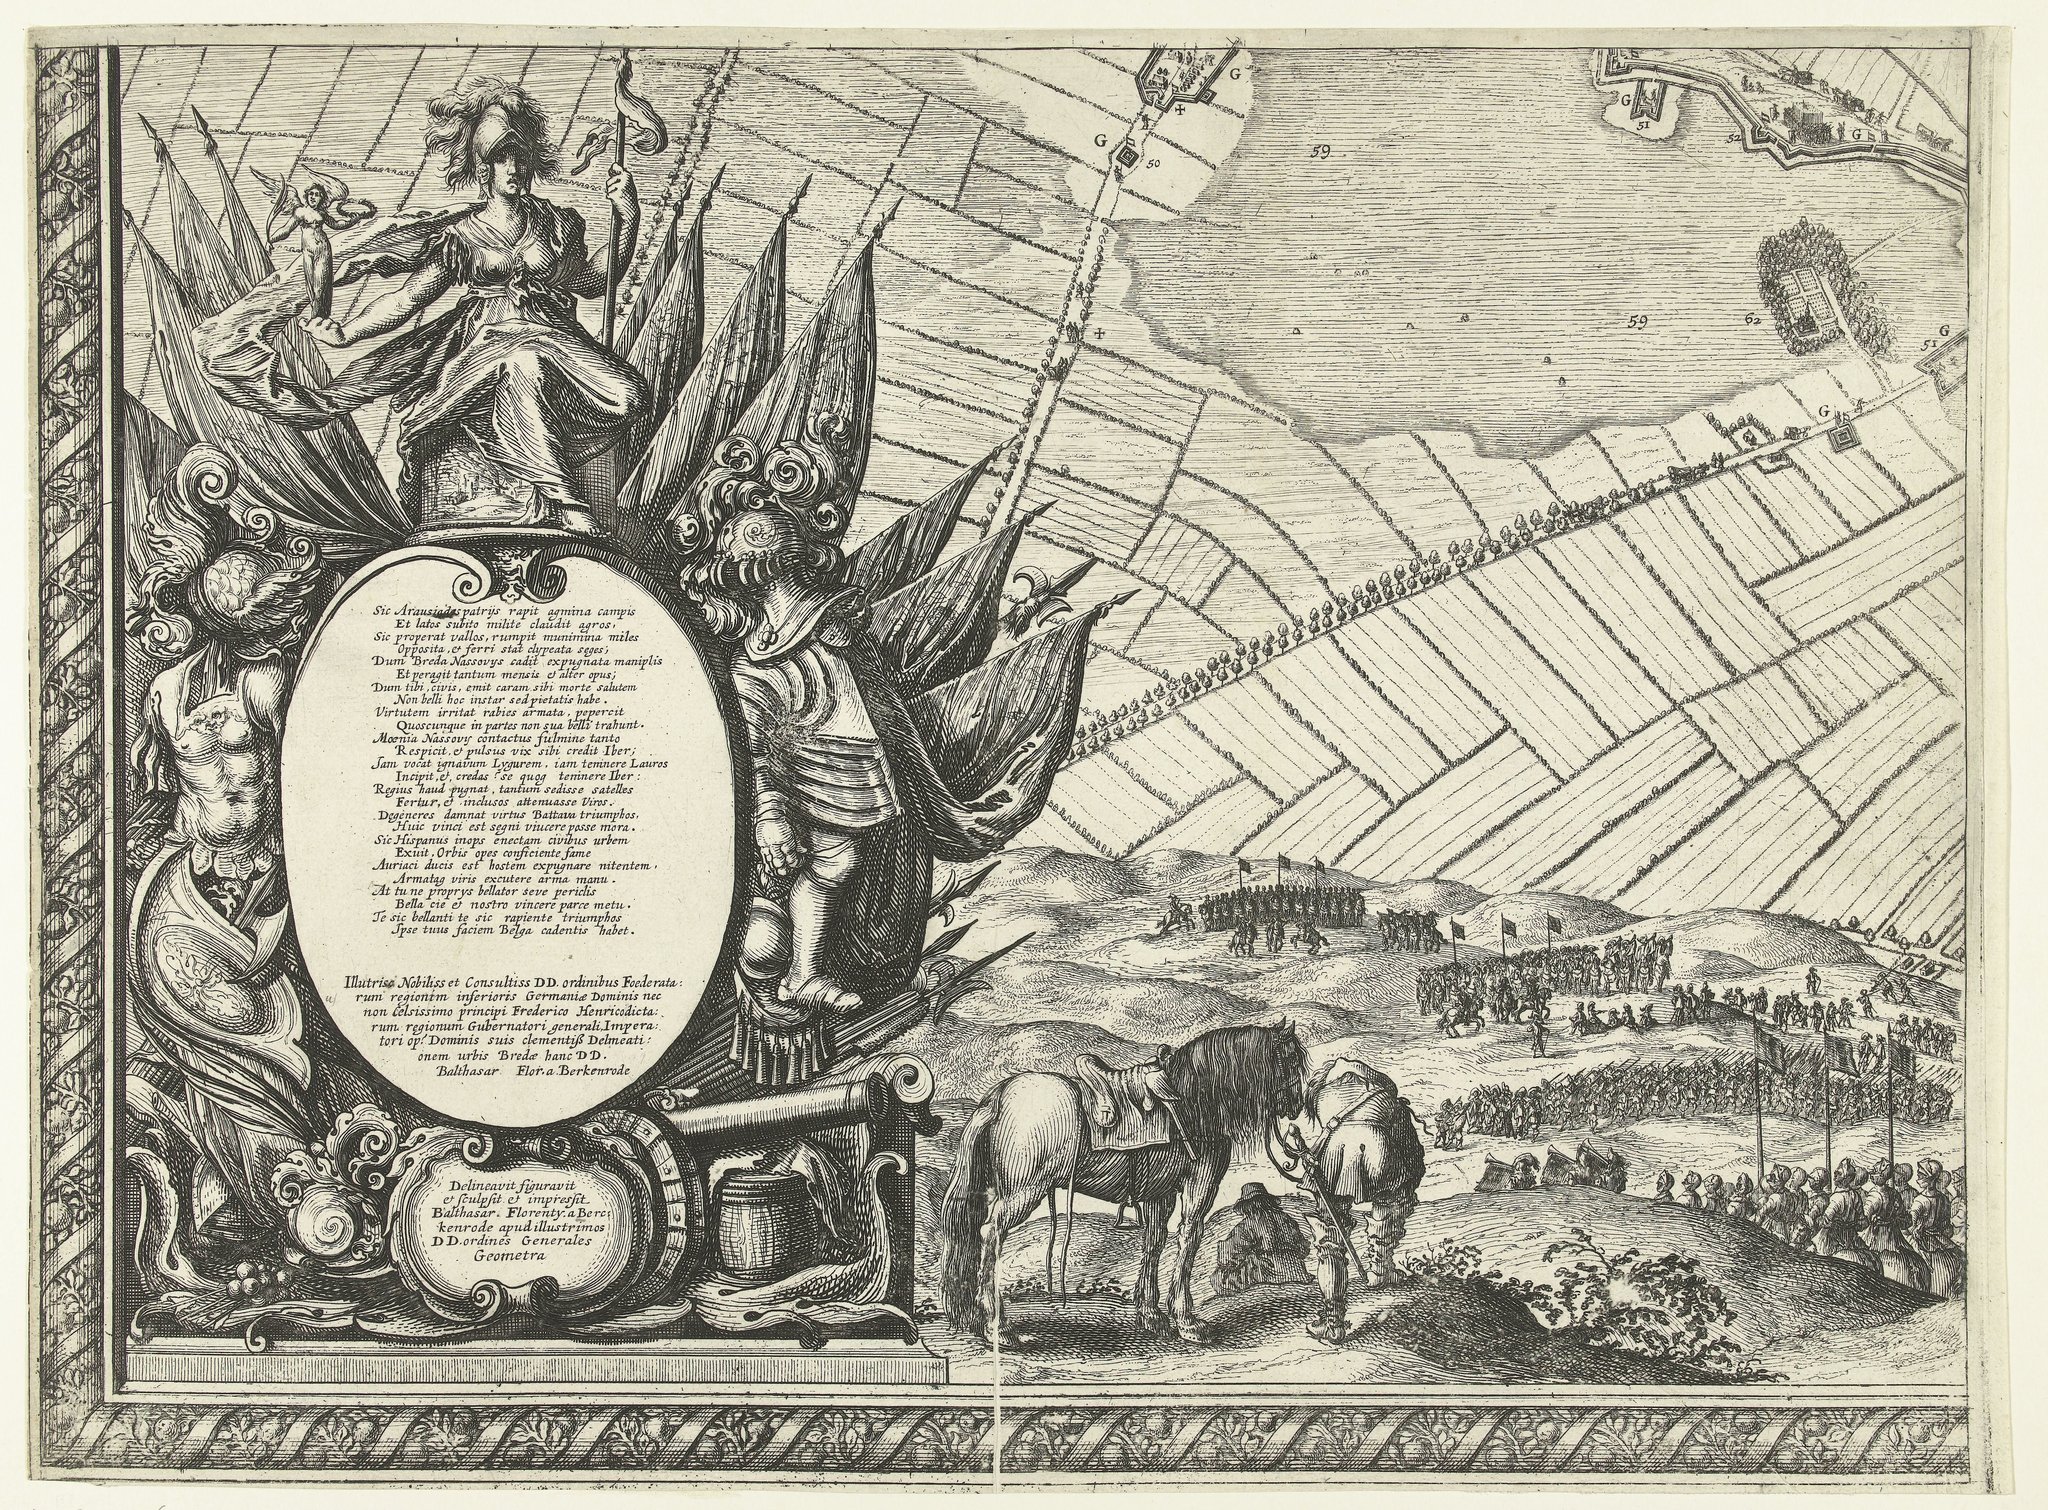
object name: print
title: Beleg van Breda (blad linksonder), 1637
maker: balthasar florisz. van berckenrode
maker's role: draughtsman, print maker, publisher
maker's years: 1591-1645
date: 1637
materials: paper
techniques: etching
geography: northern netherlands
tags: delft, the hague, frederick henry (prince of orange), maps of separate countries or regions, siege, position war, 'victoria'; 'vittoria', 'vittoria navale', 'vittoria degl'antichi' (ripa)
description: De belegering en verovering van Breda door het Staatse leger onder Frederik Hendrik, 23 juli - 10 oktober 1637. Onderdeel van een ongemonteerde ensemble bestaande uit 9 bladen (en 2 hier ontbrekende tekstbladen). Blad linksonder met een deel van de kaart en de cartouche met een vers en de opdracht in het Latijn. De cartouche versierd met allerlei wapentuig, vaandels en harnassen, bovenop de personificatie van de Overwinning (Victoria).